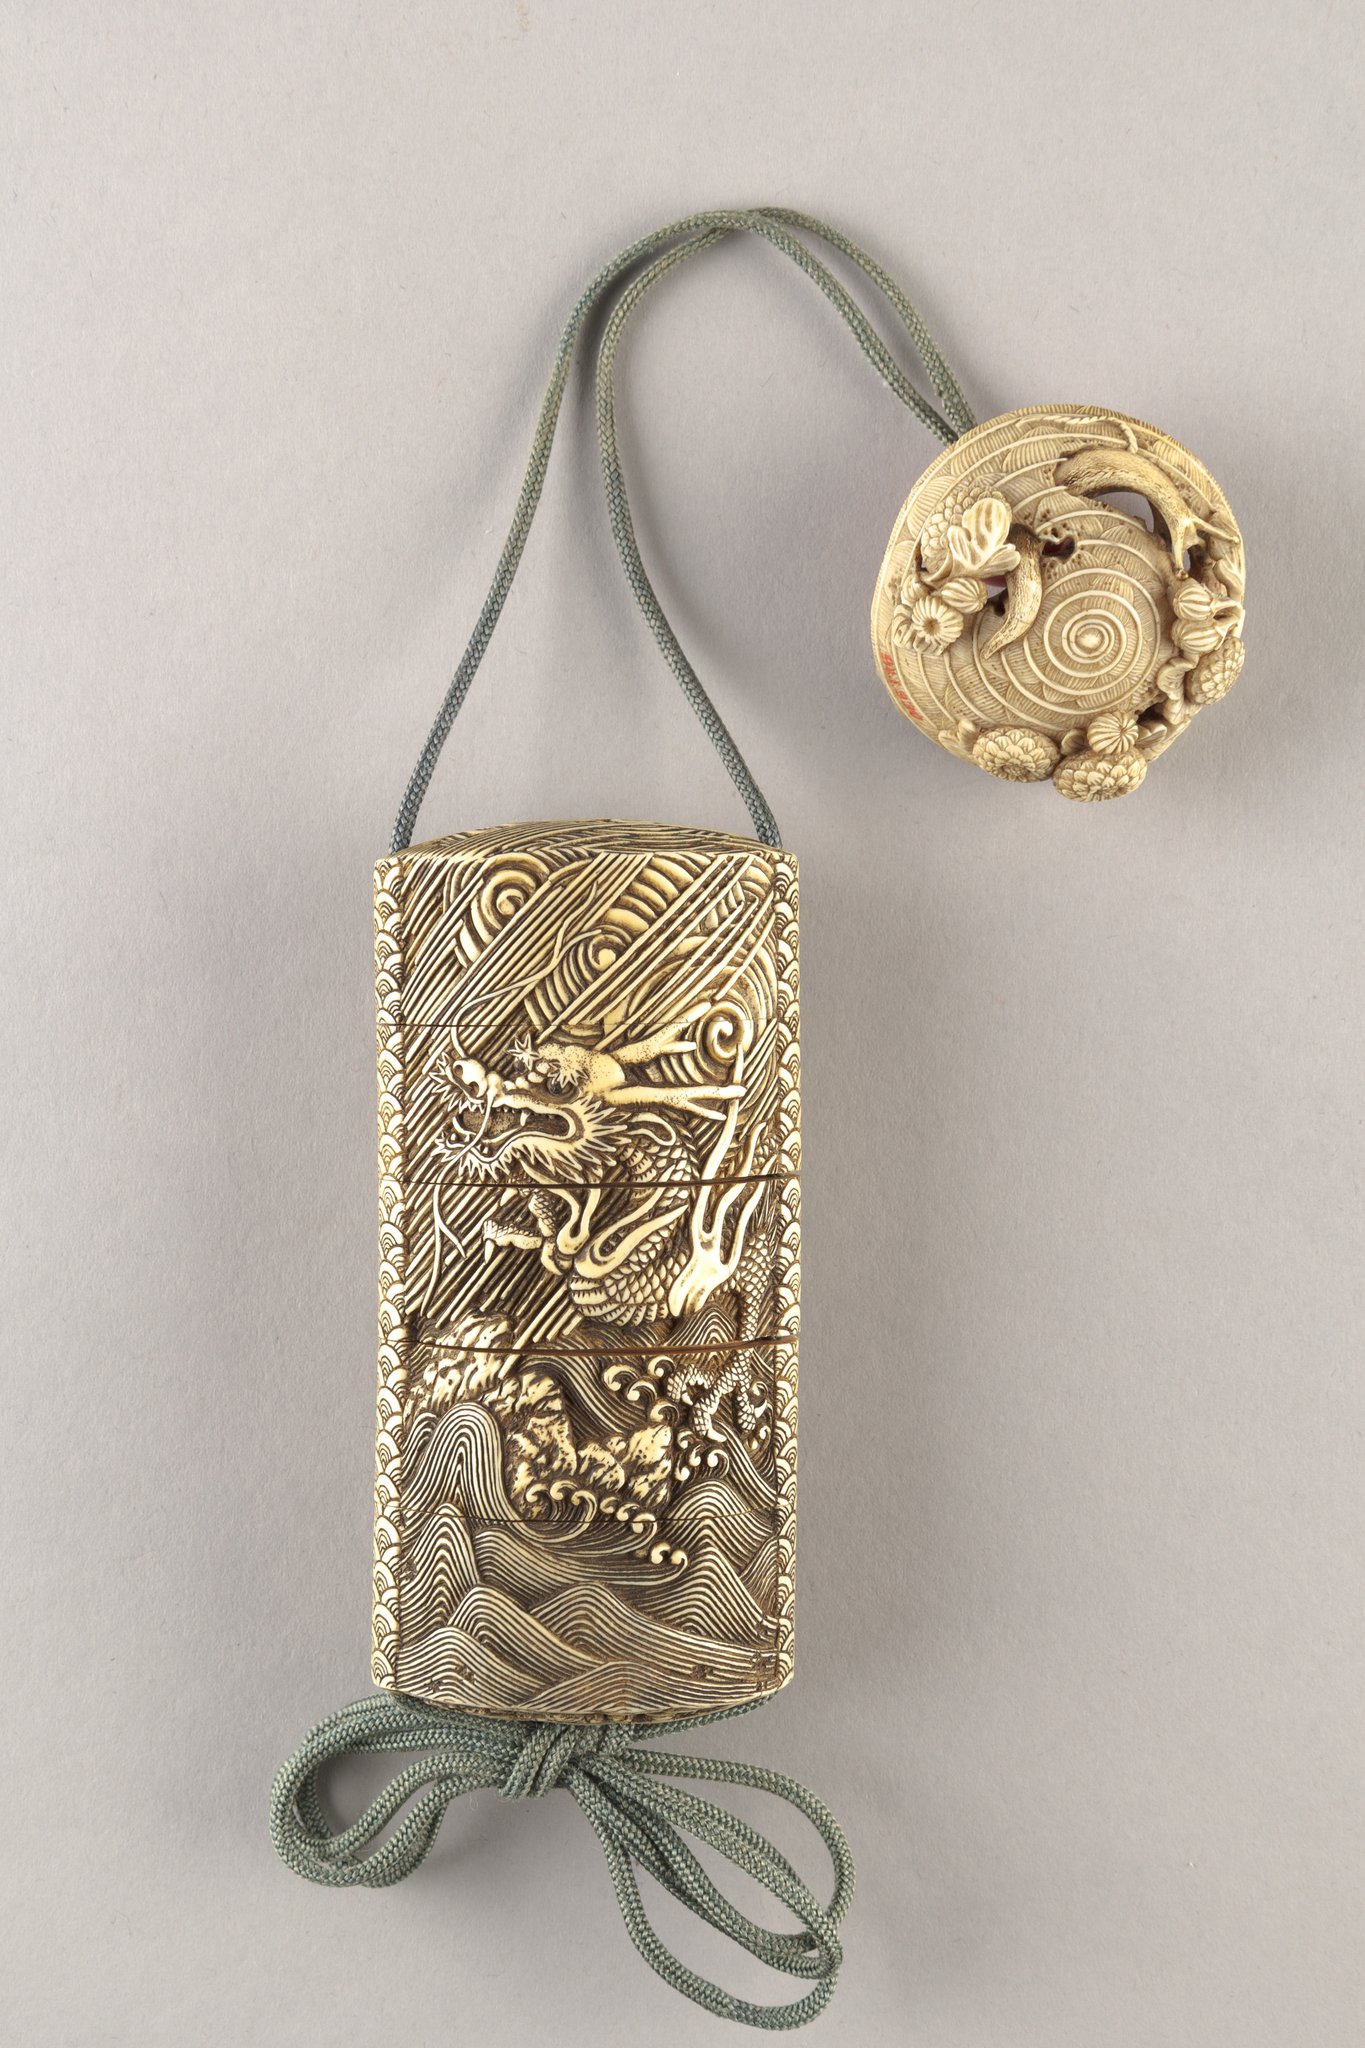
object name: inrō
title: Case (Inrō) with Design of Three-Clawed Dragon in Rain and Swirling Clouds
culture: japanese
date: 1801-1900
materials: ivory, lacquer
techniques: carving, relief, stain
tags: dragons,clouds